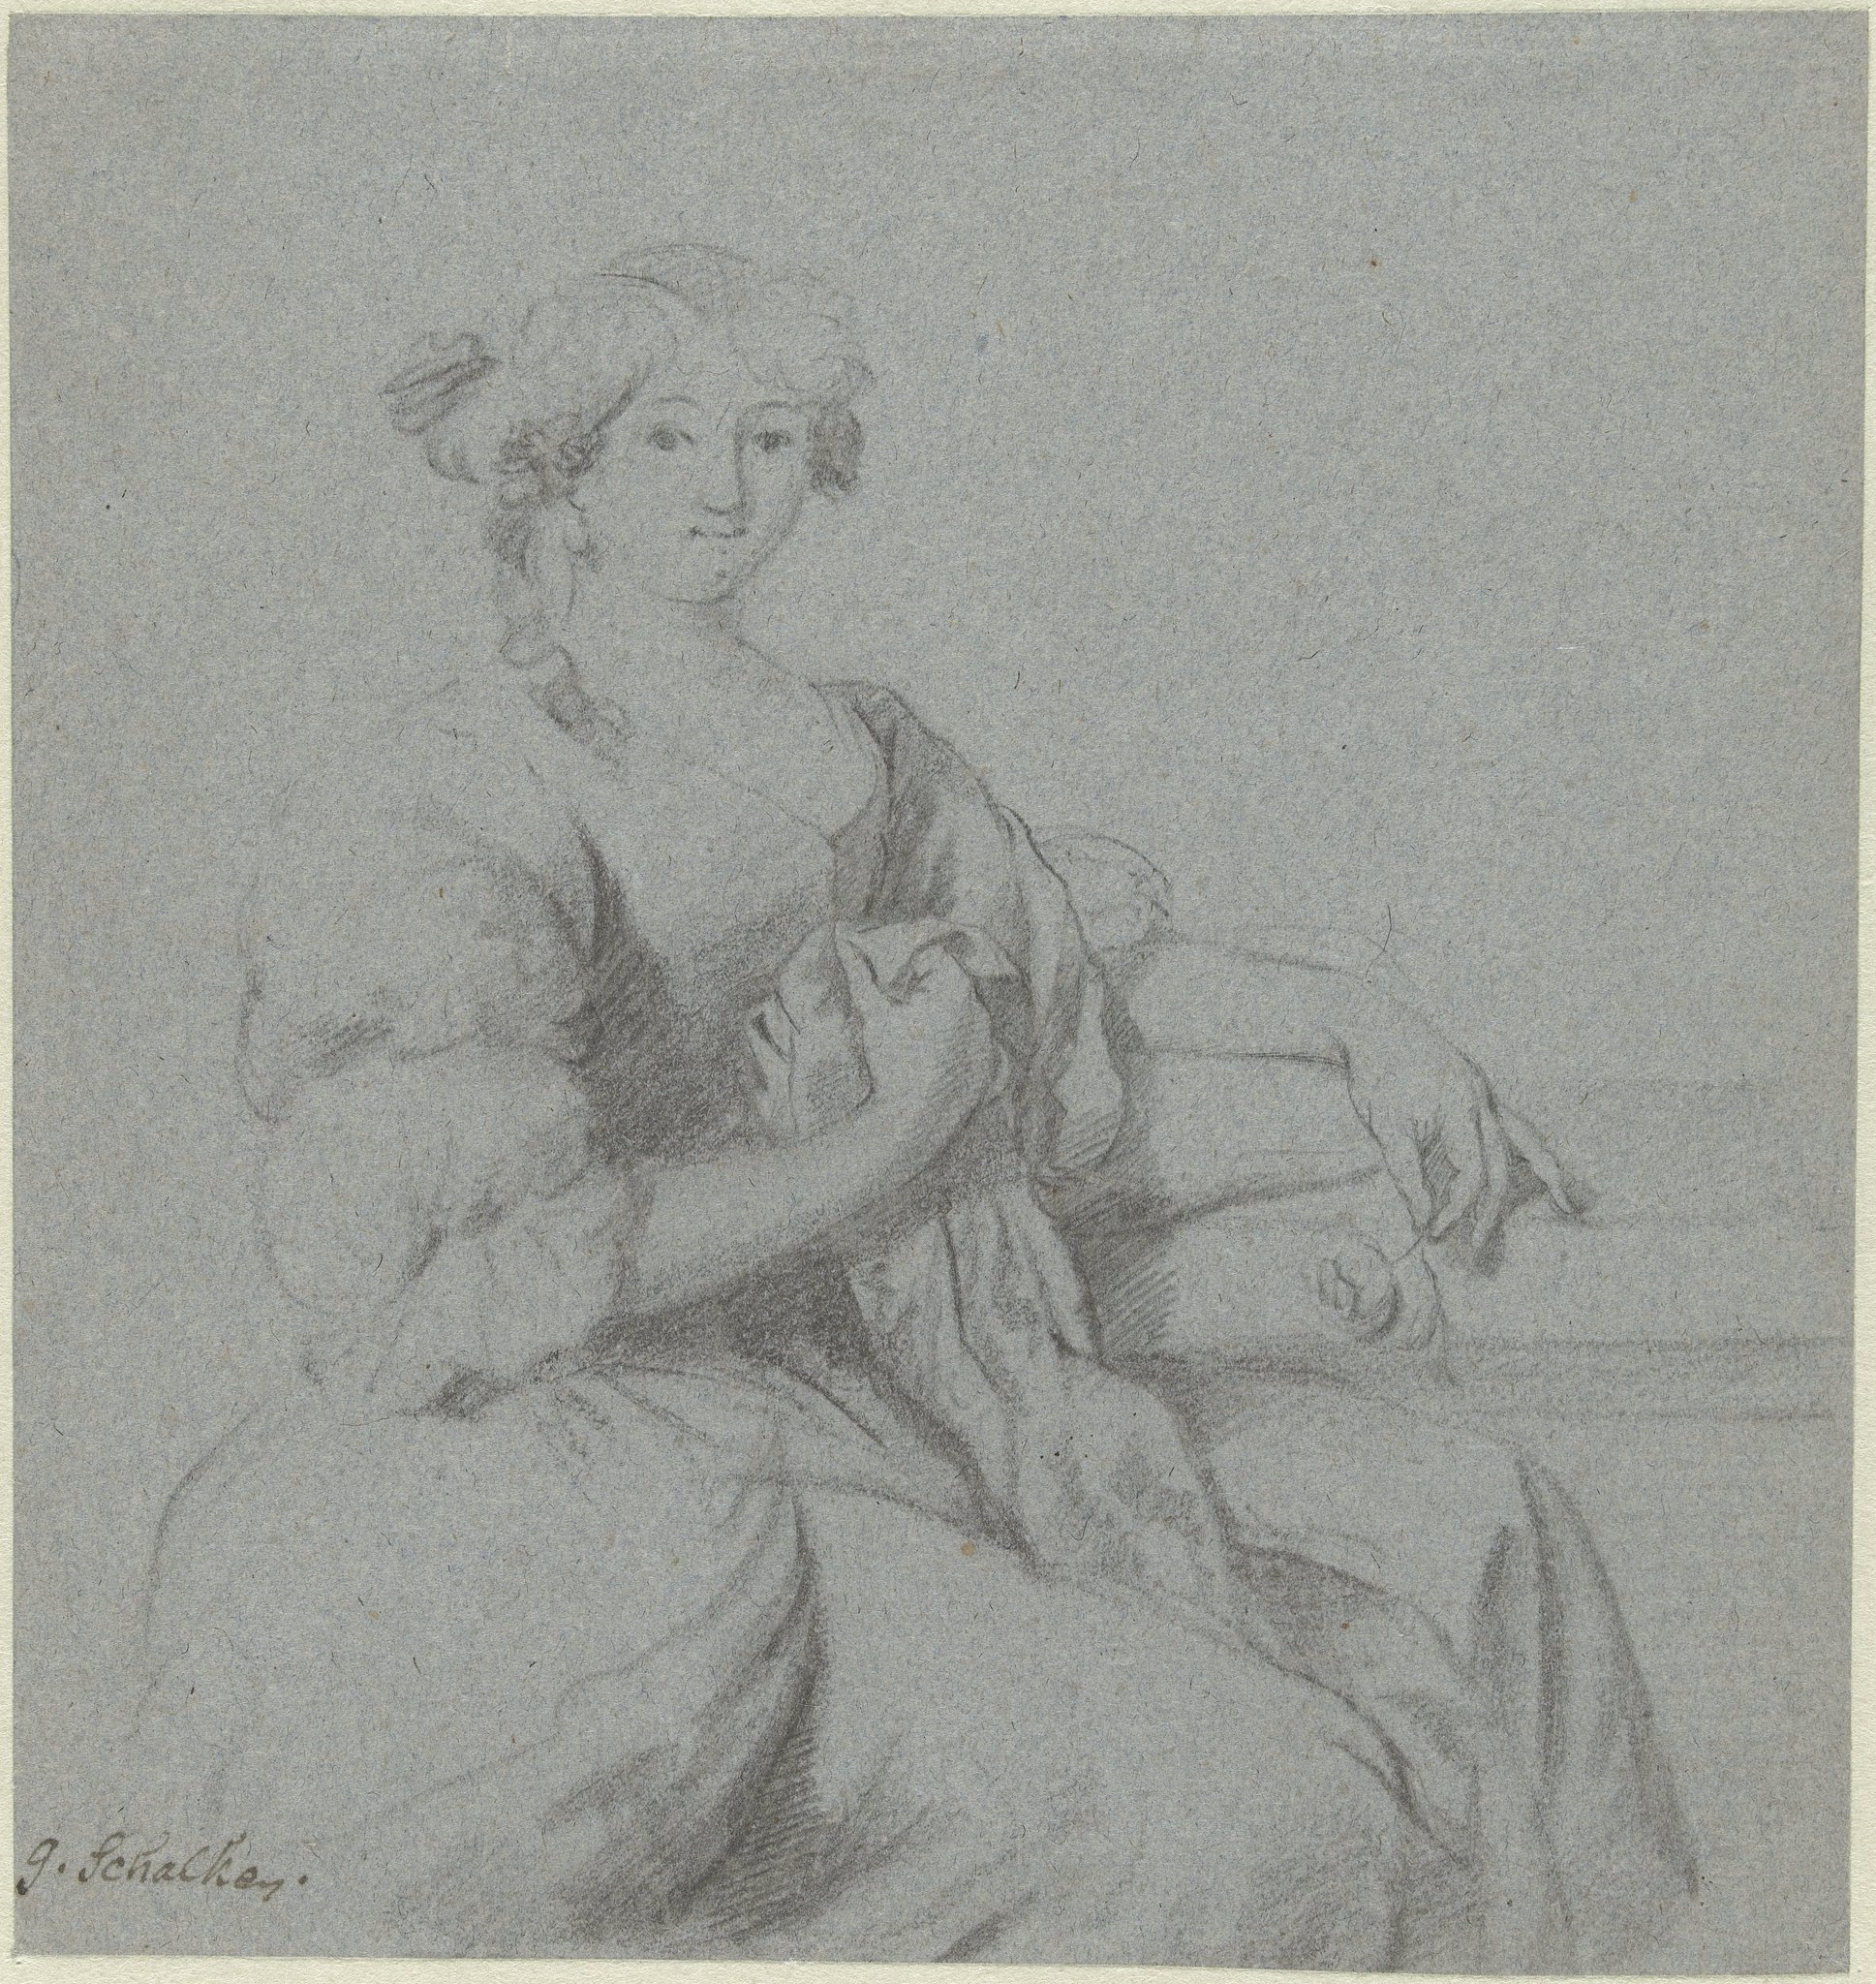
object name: drawing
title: Zittende vrouw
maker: godfried schalcken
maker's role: draughtsman, painter, print maker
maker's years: 1643-1706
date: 1679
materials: chalk, paper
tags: sitting figure - aa - female human figure, anonymous historical person portrayed alone